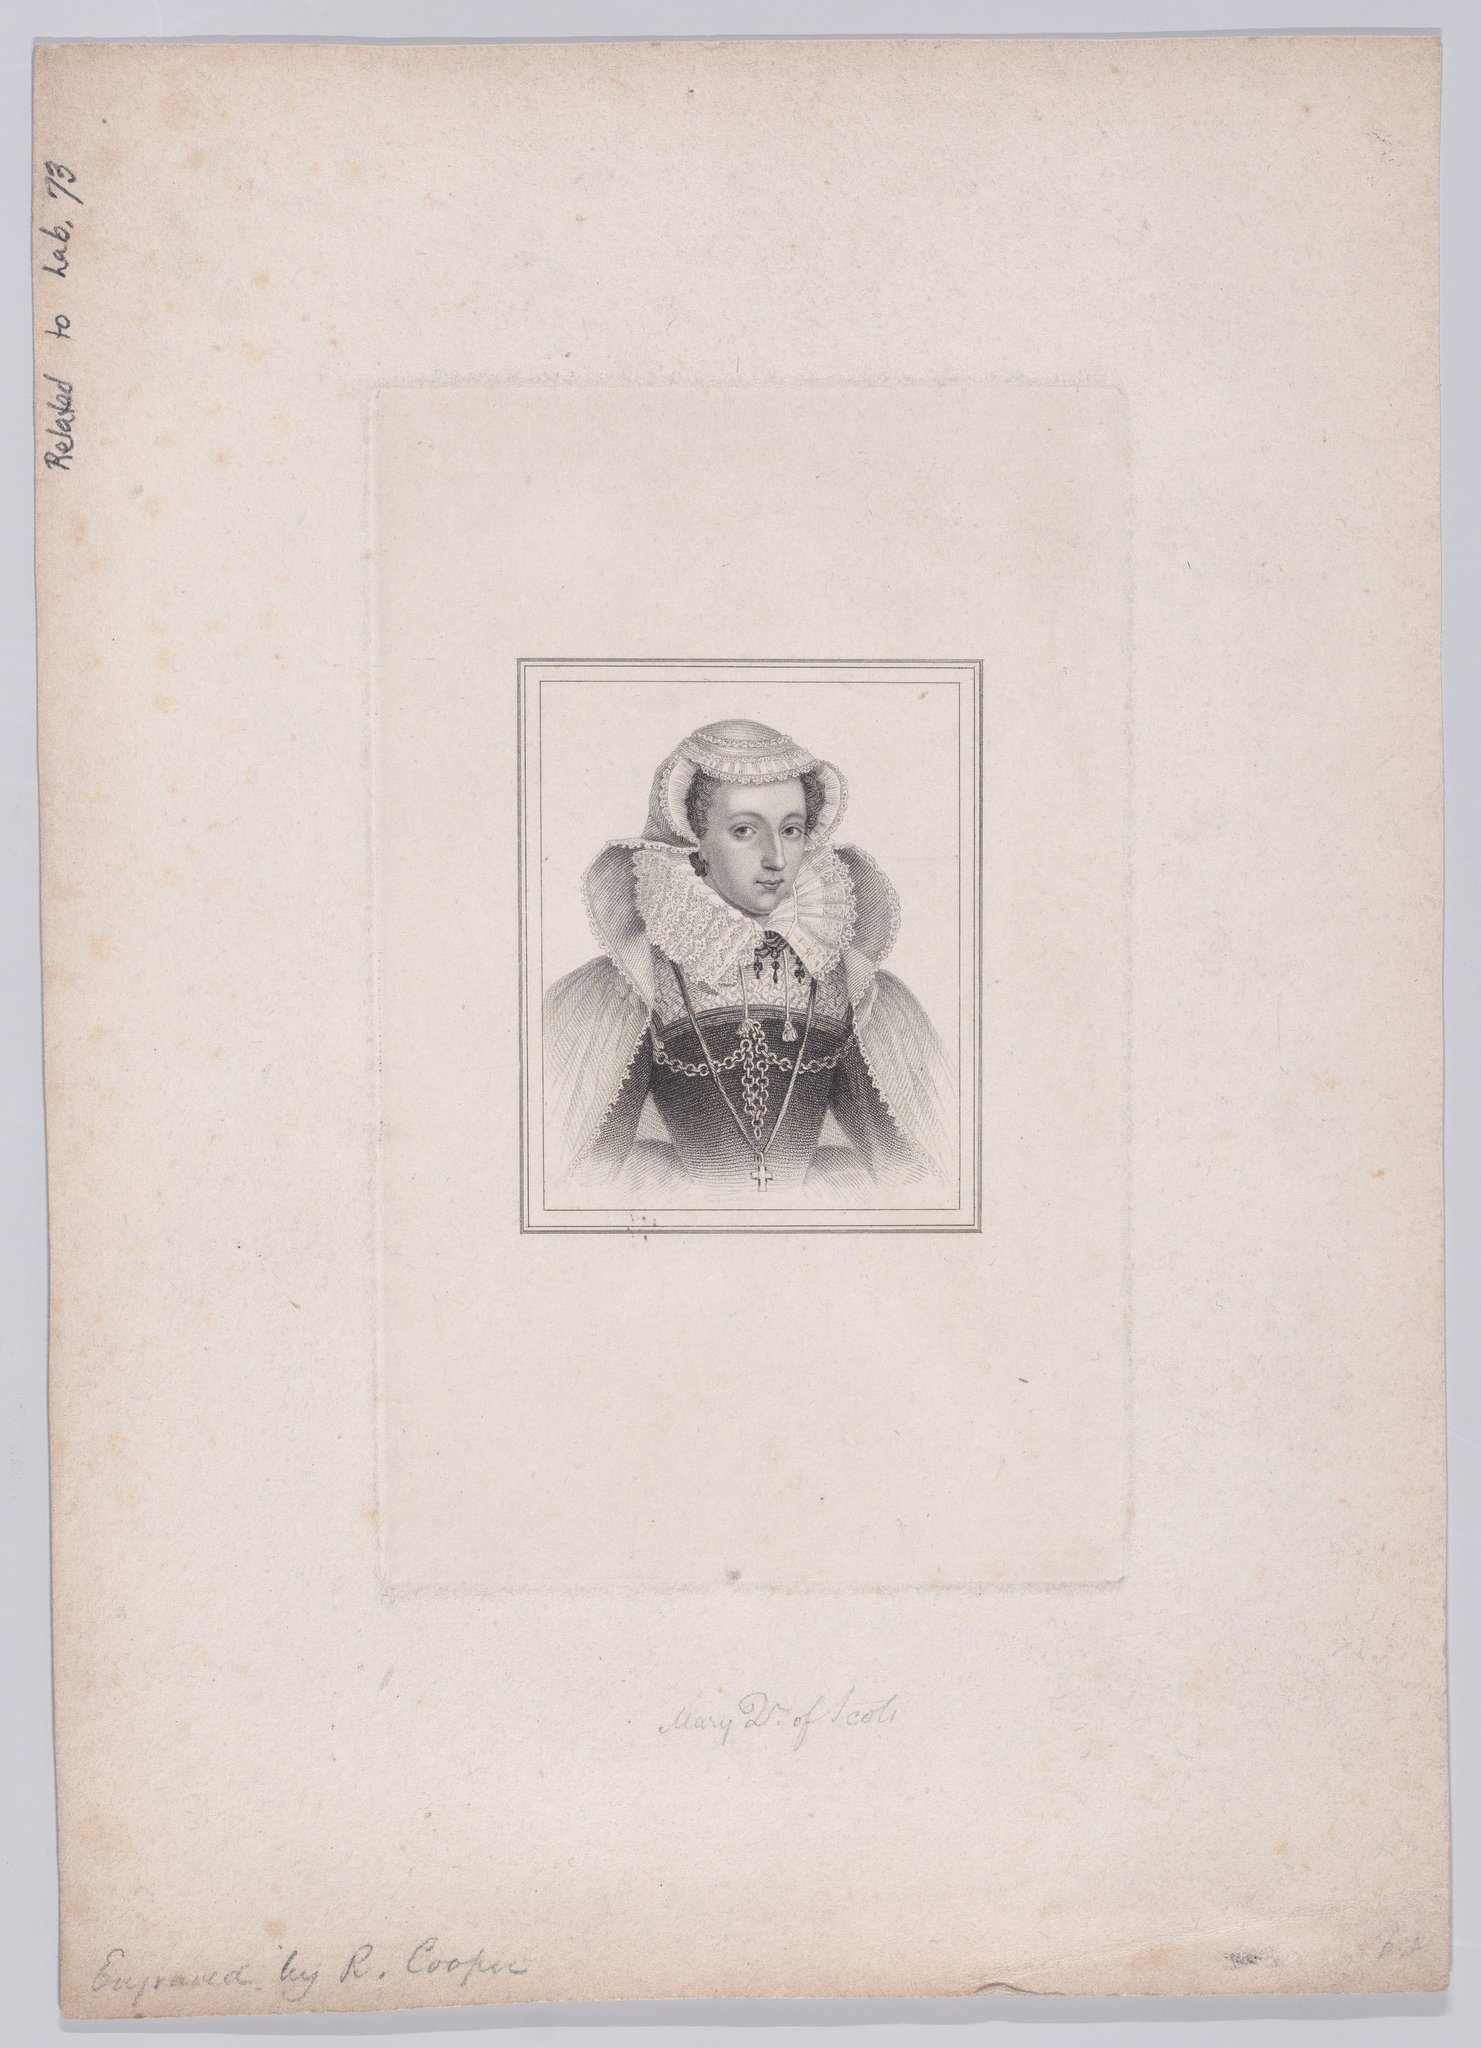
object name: print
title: Mary, Queen of Scots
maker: robert cooper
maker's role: artist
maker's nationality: british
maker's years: -1828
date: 1801-1833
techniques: engraving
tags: portraits,women,mary queen of scots